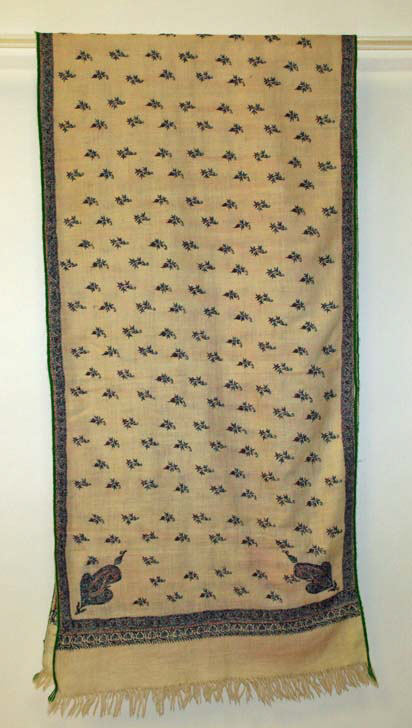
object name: chudar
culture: indian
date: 1801-1900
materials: wool